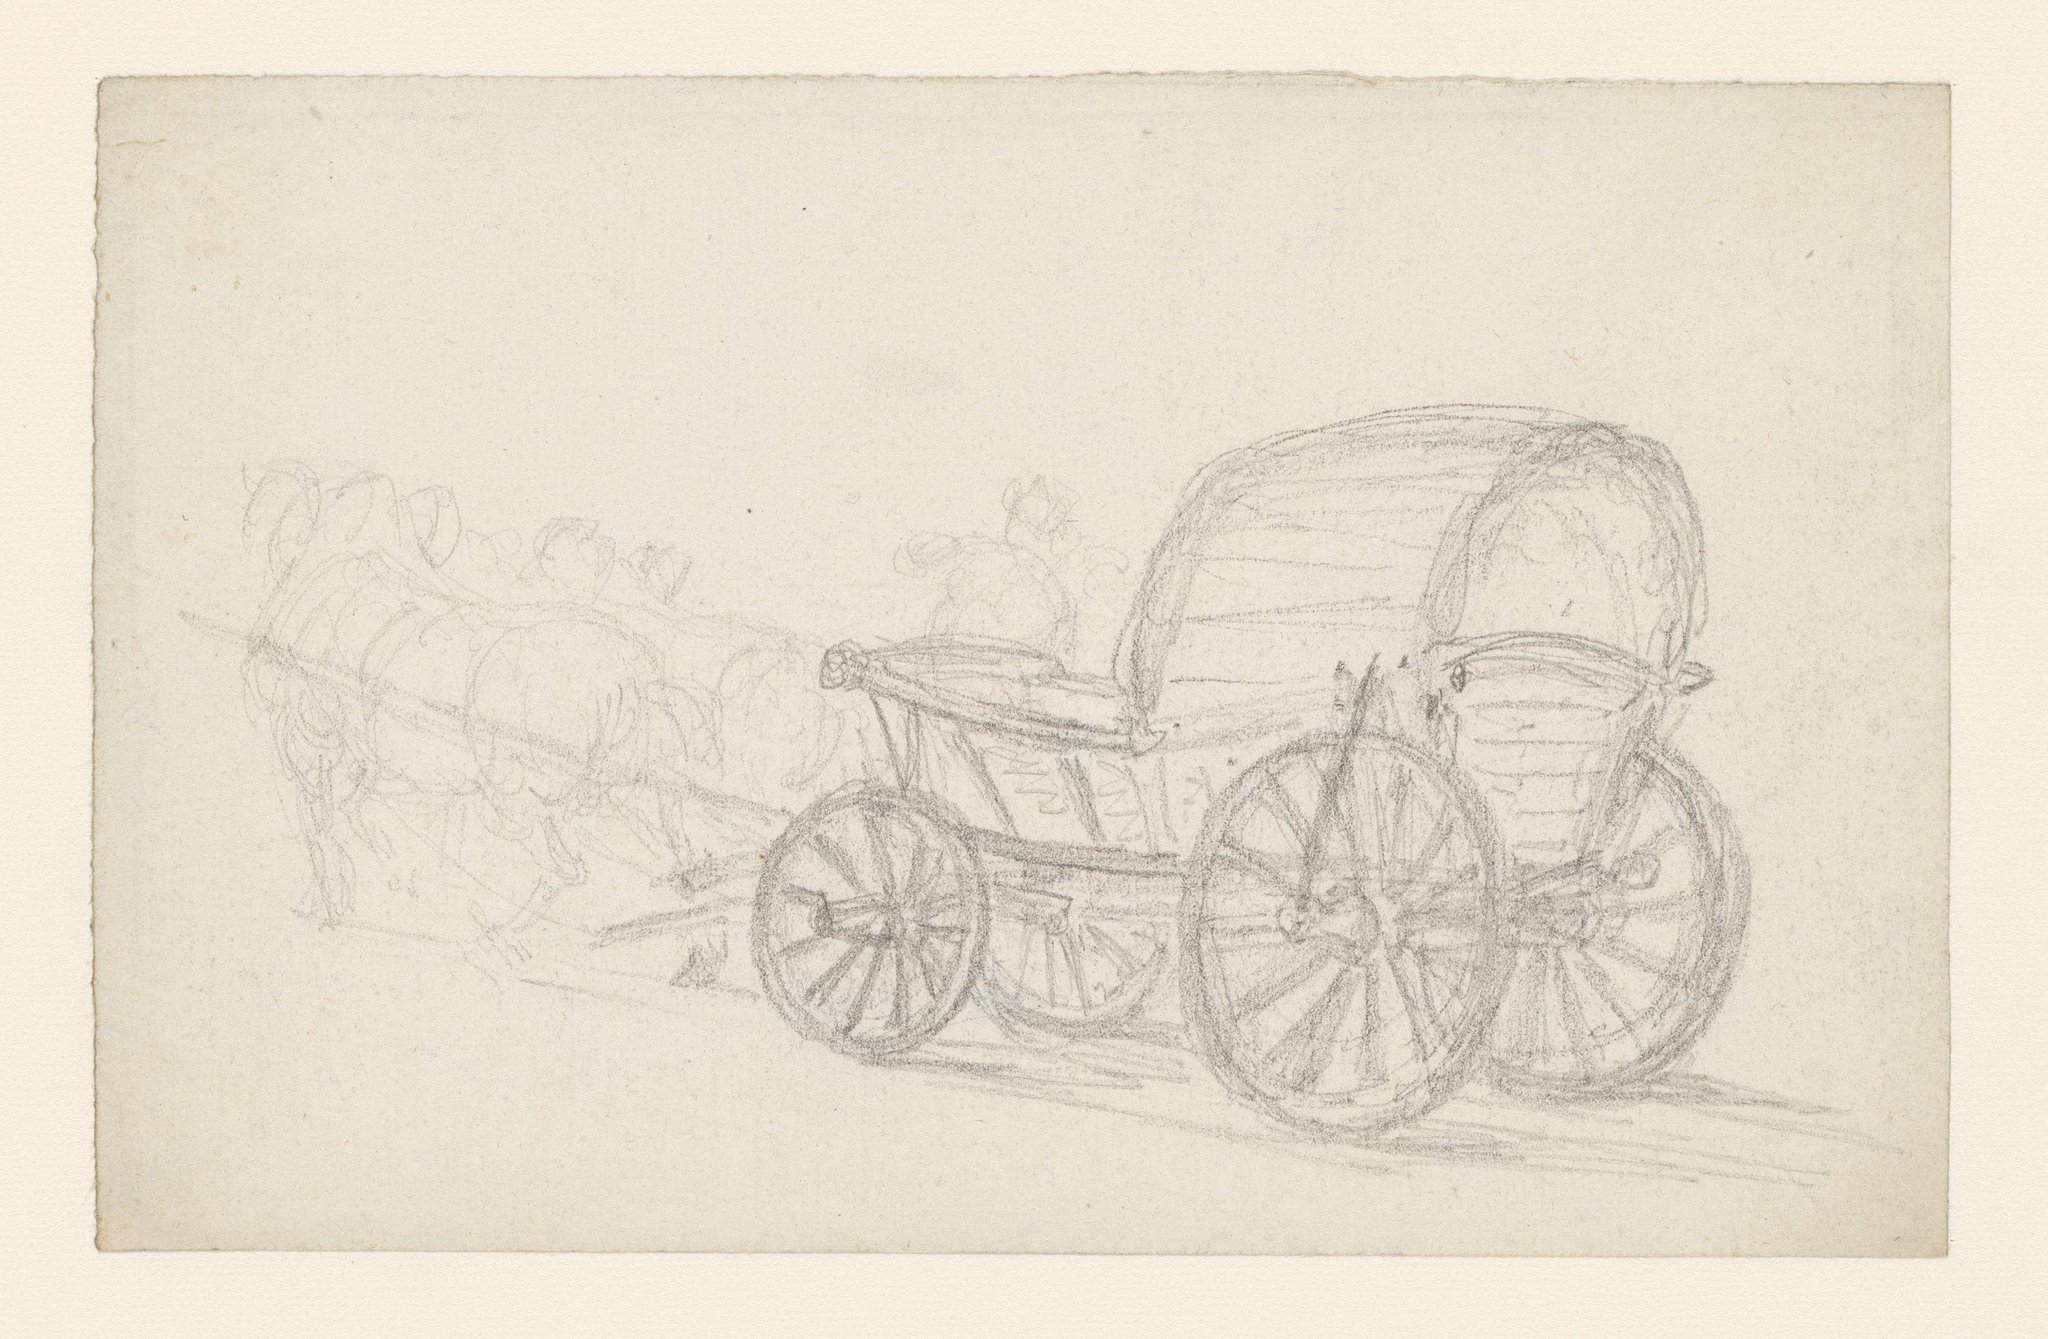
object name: drawing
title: Boerenkar naar links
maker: georges michel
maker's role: draughtsman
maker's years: 1763-1843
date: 1773-1843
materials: paper, pencil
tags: covered wagon, hooded wagon, four-wheeled vehicle drawn by two animals, (farm) wagon, freight wagon, cart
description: Een van 120 tekeningen, afkomstig uit een 19e eeuws album met tekeningen van Georges Michel.